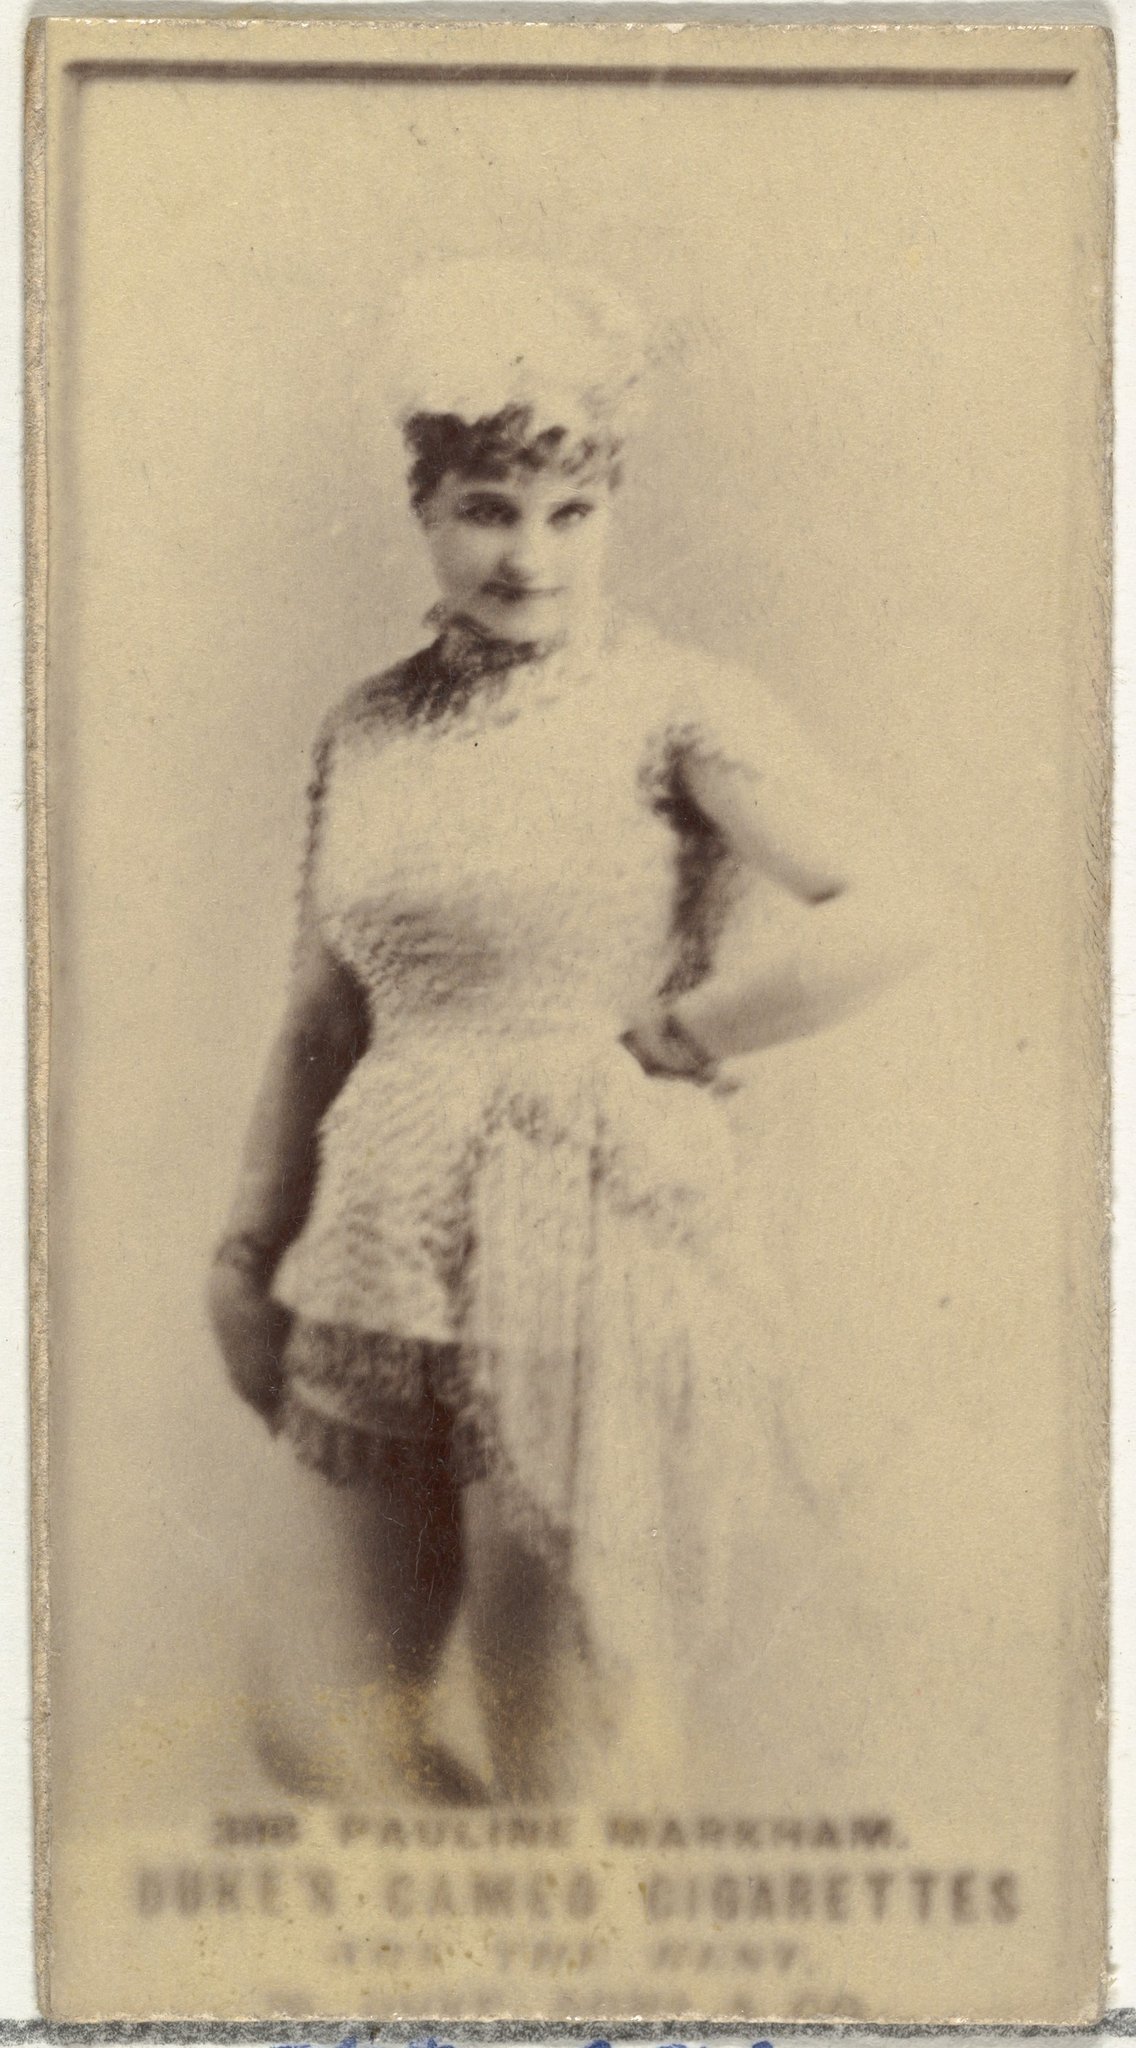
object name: photograph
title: Card Number 388, Pauline Markham, from the Actors and Actresses series (N145-5) issued by Duke Sons & Co. to promote Cameo Cigarettes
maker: w. duke, sons & co.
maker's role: publisher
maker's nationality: american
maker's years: 1870-1920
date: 1880-1889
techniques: albumen silver print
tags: portraits,women,actresses